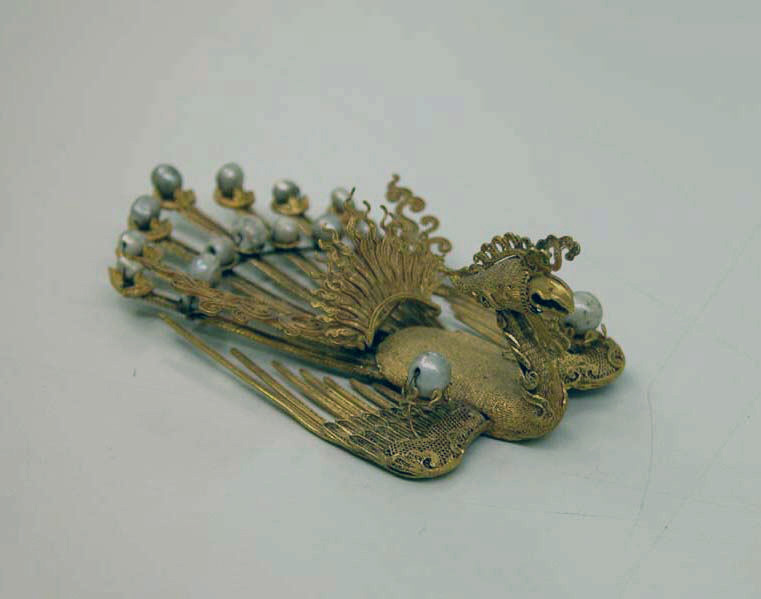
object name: ornament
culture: chinese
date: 960-1279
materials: gold, pearl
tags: birds